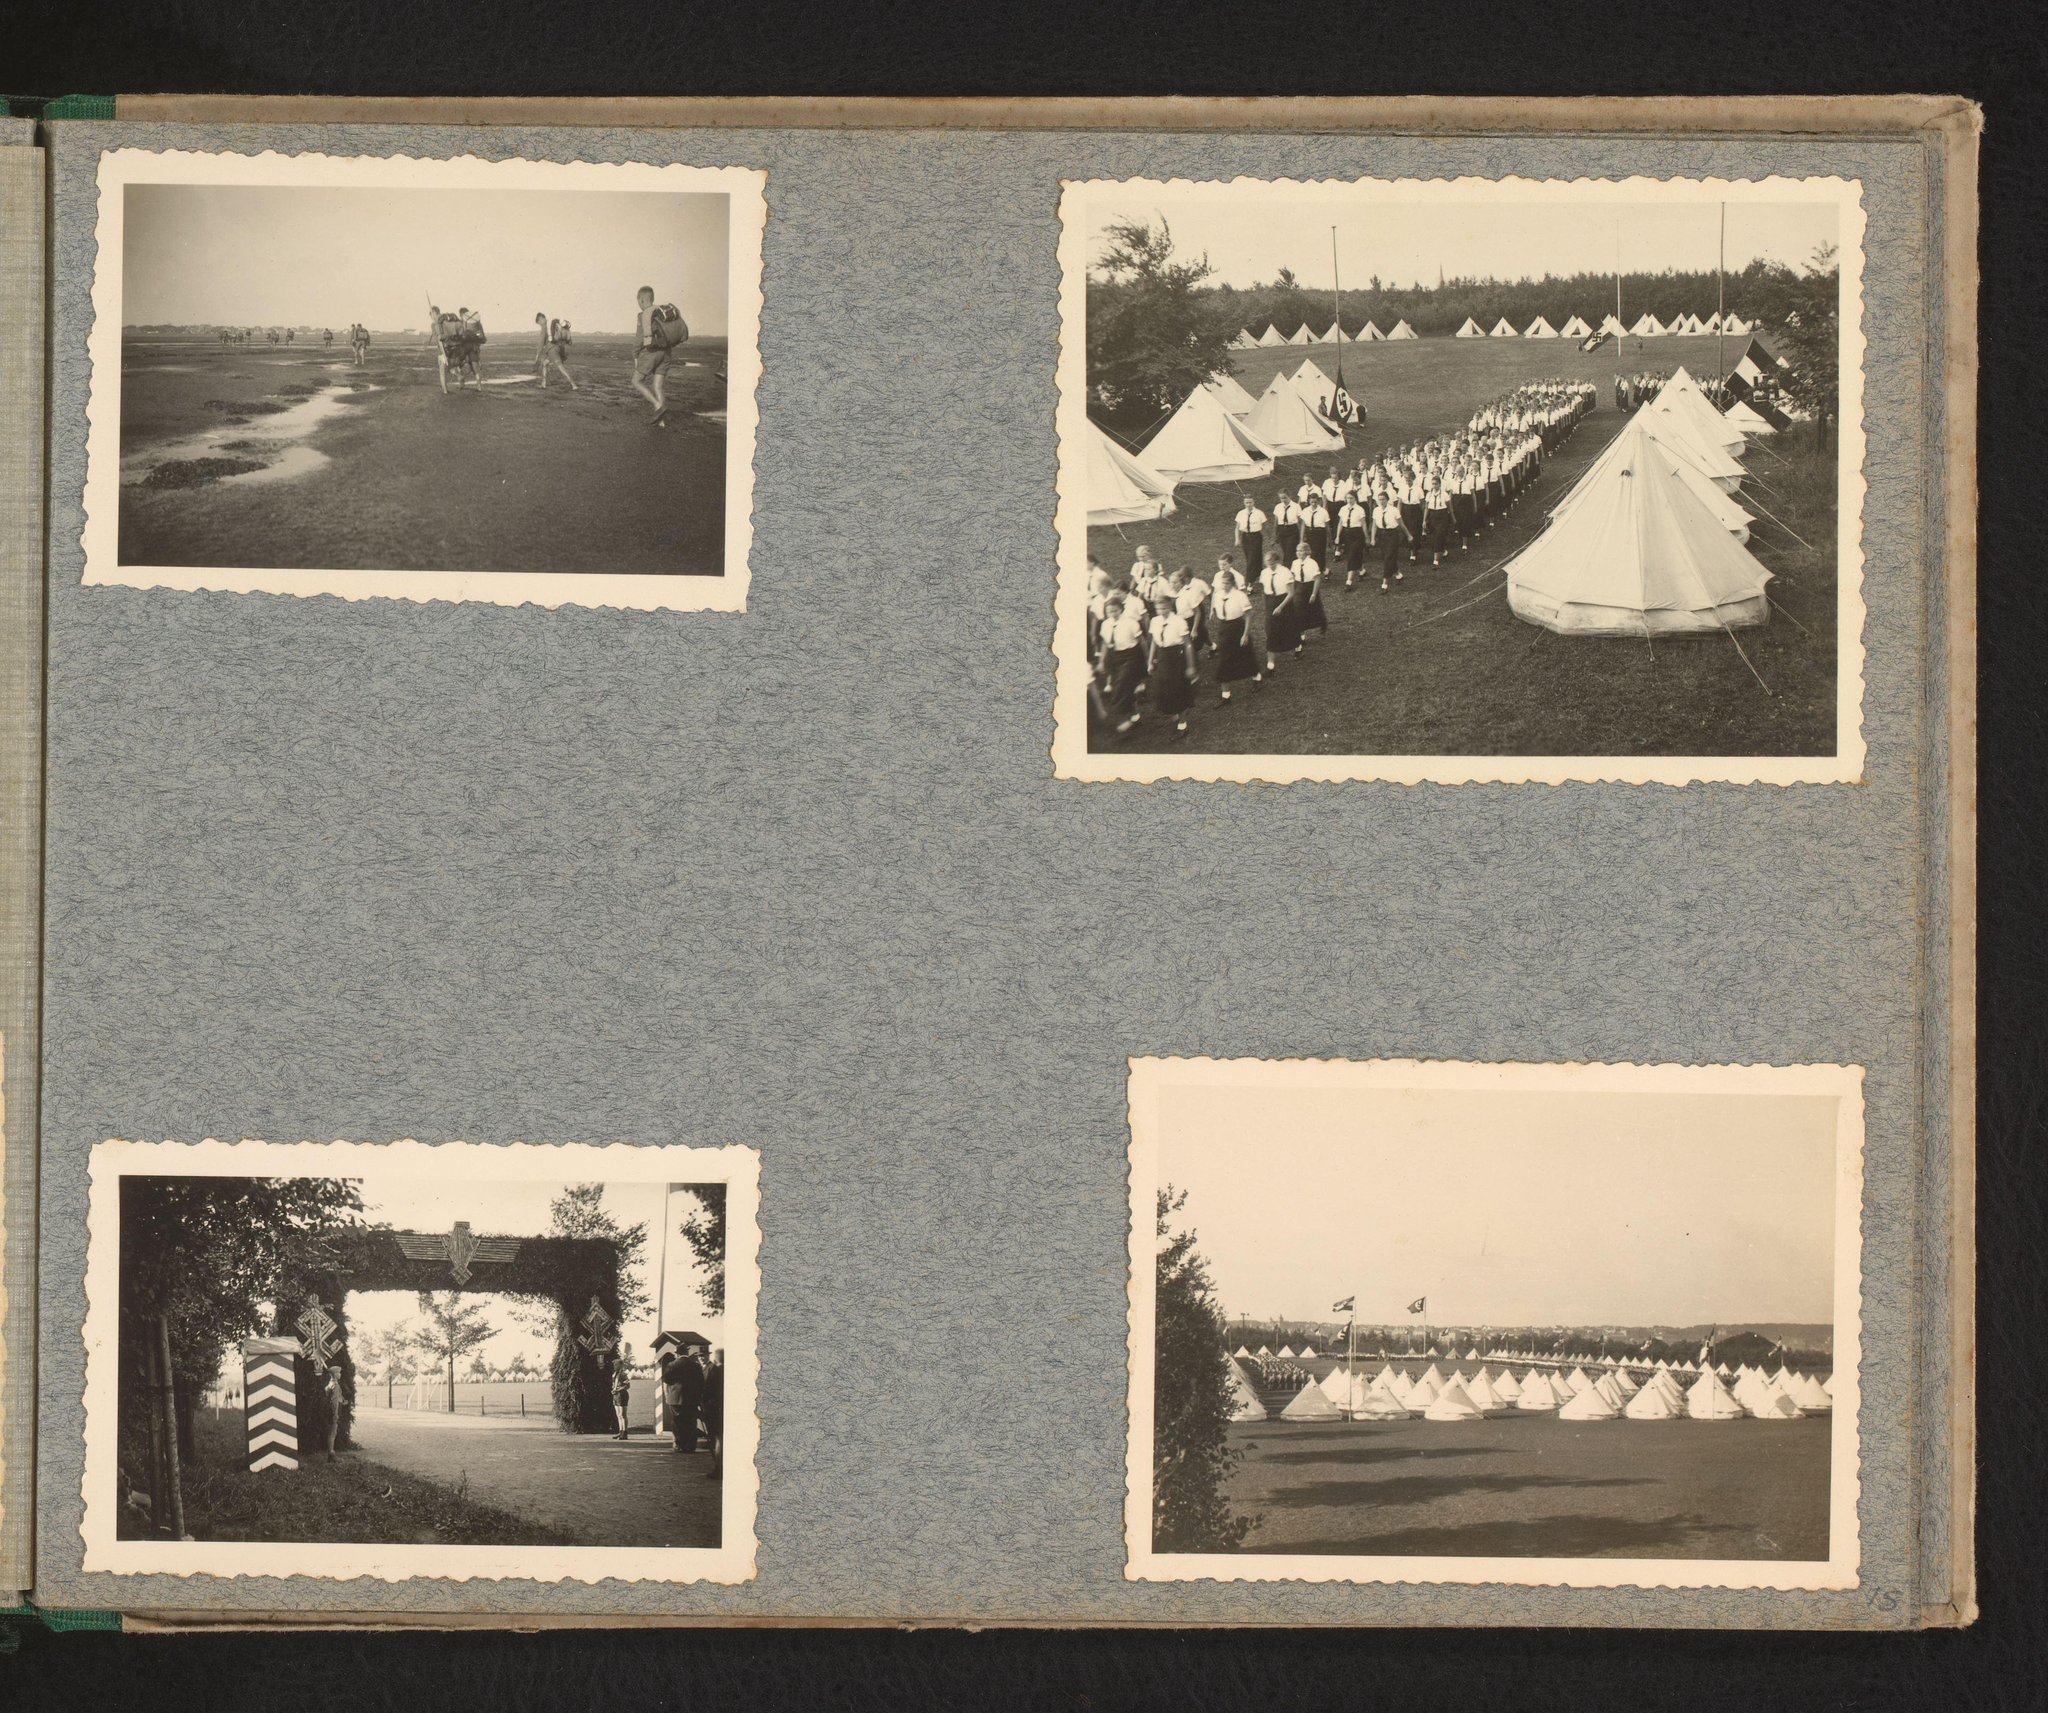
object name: album leaf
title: Tentenkamp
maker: Anonymous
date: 1935-1938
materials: cardboard, photographic support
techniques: gelatin silver print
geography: germany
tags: (military) camp with tents, military training, germany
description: Albumblad met vier foto's van een wandeltocht en van een tentenkamp van de Hitlerjugend en de Bund Deutscher Mädel. Jongens van de Hitlerjugend van Landjahrlager 1935 in Wolmersdorf. Onderdeel van het Hitlerjugend fotoalbum.